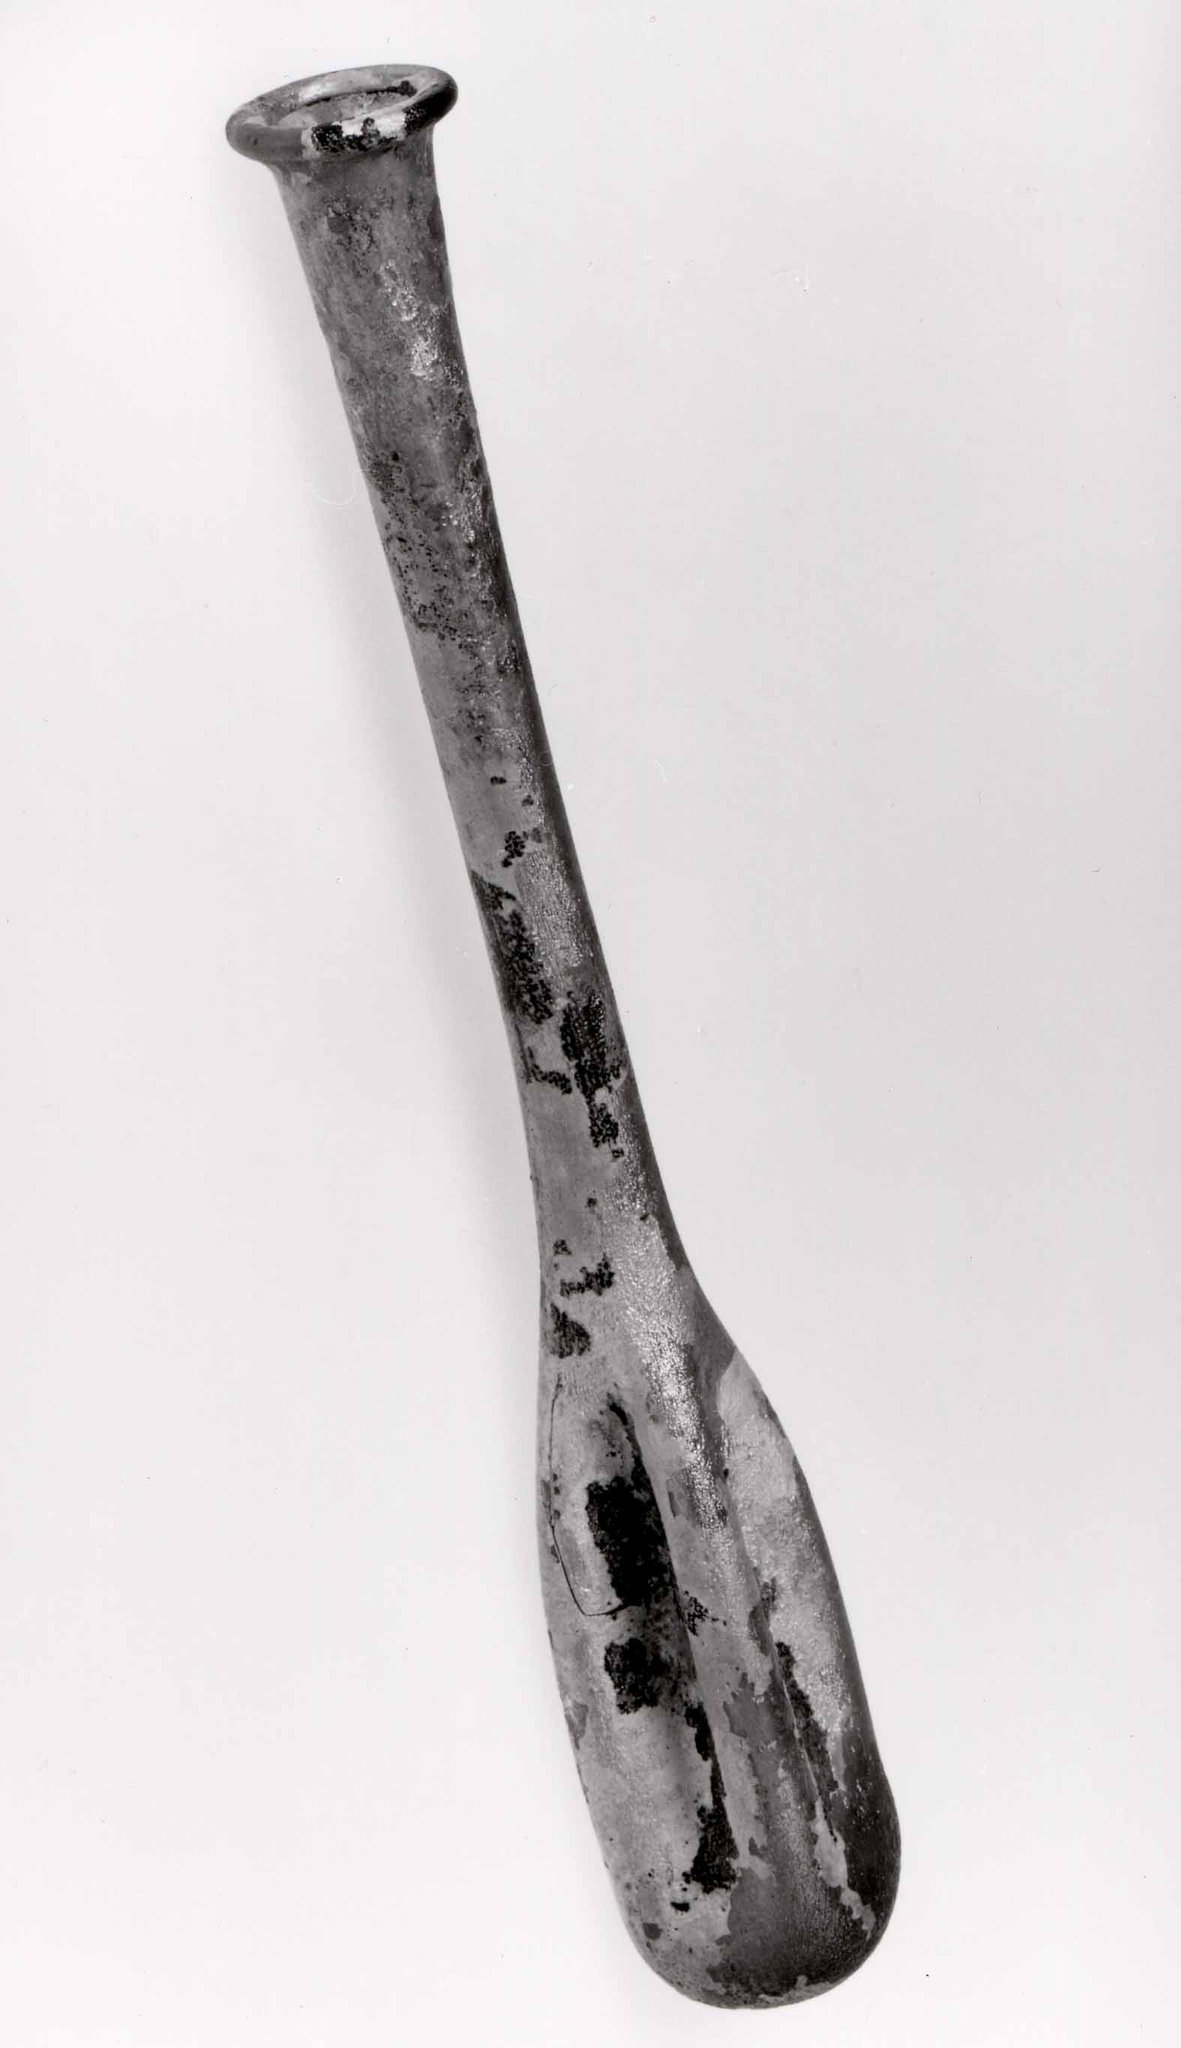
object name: bottle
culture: roman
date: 67-300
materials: glass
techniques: glassblowing, tooling